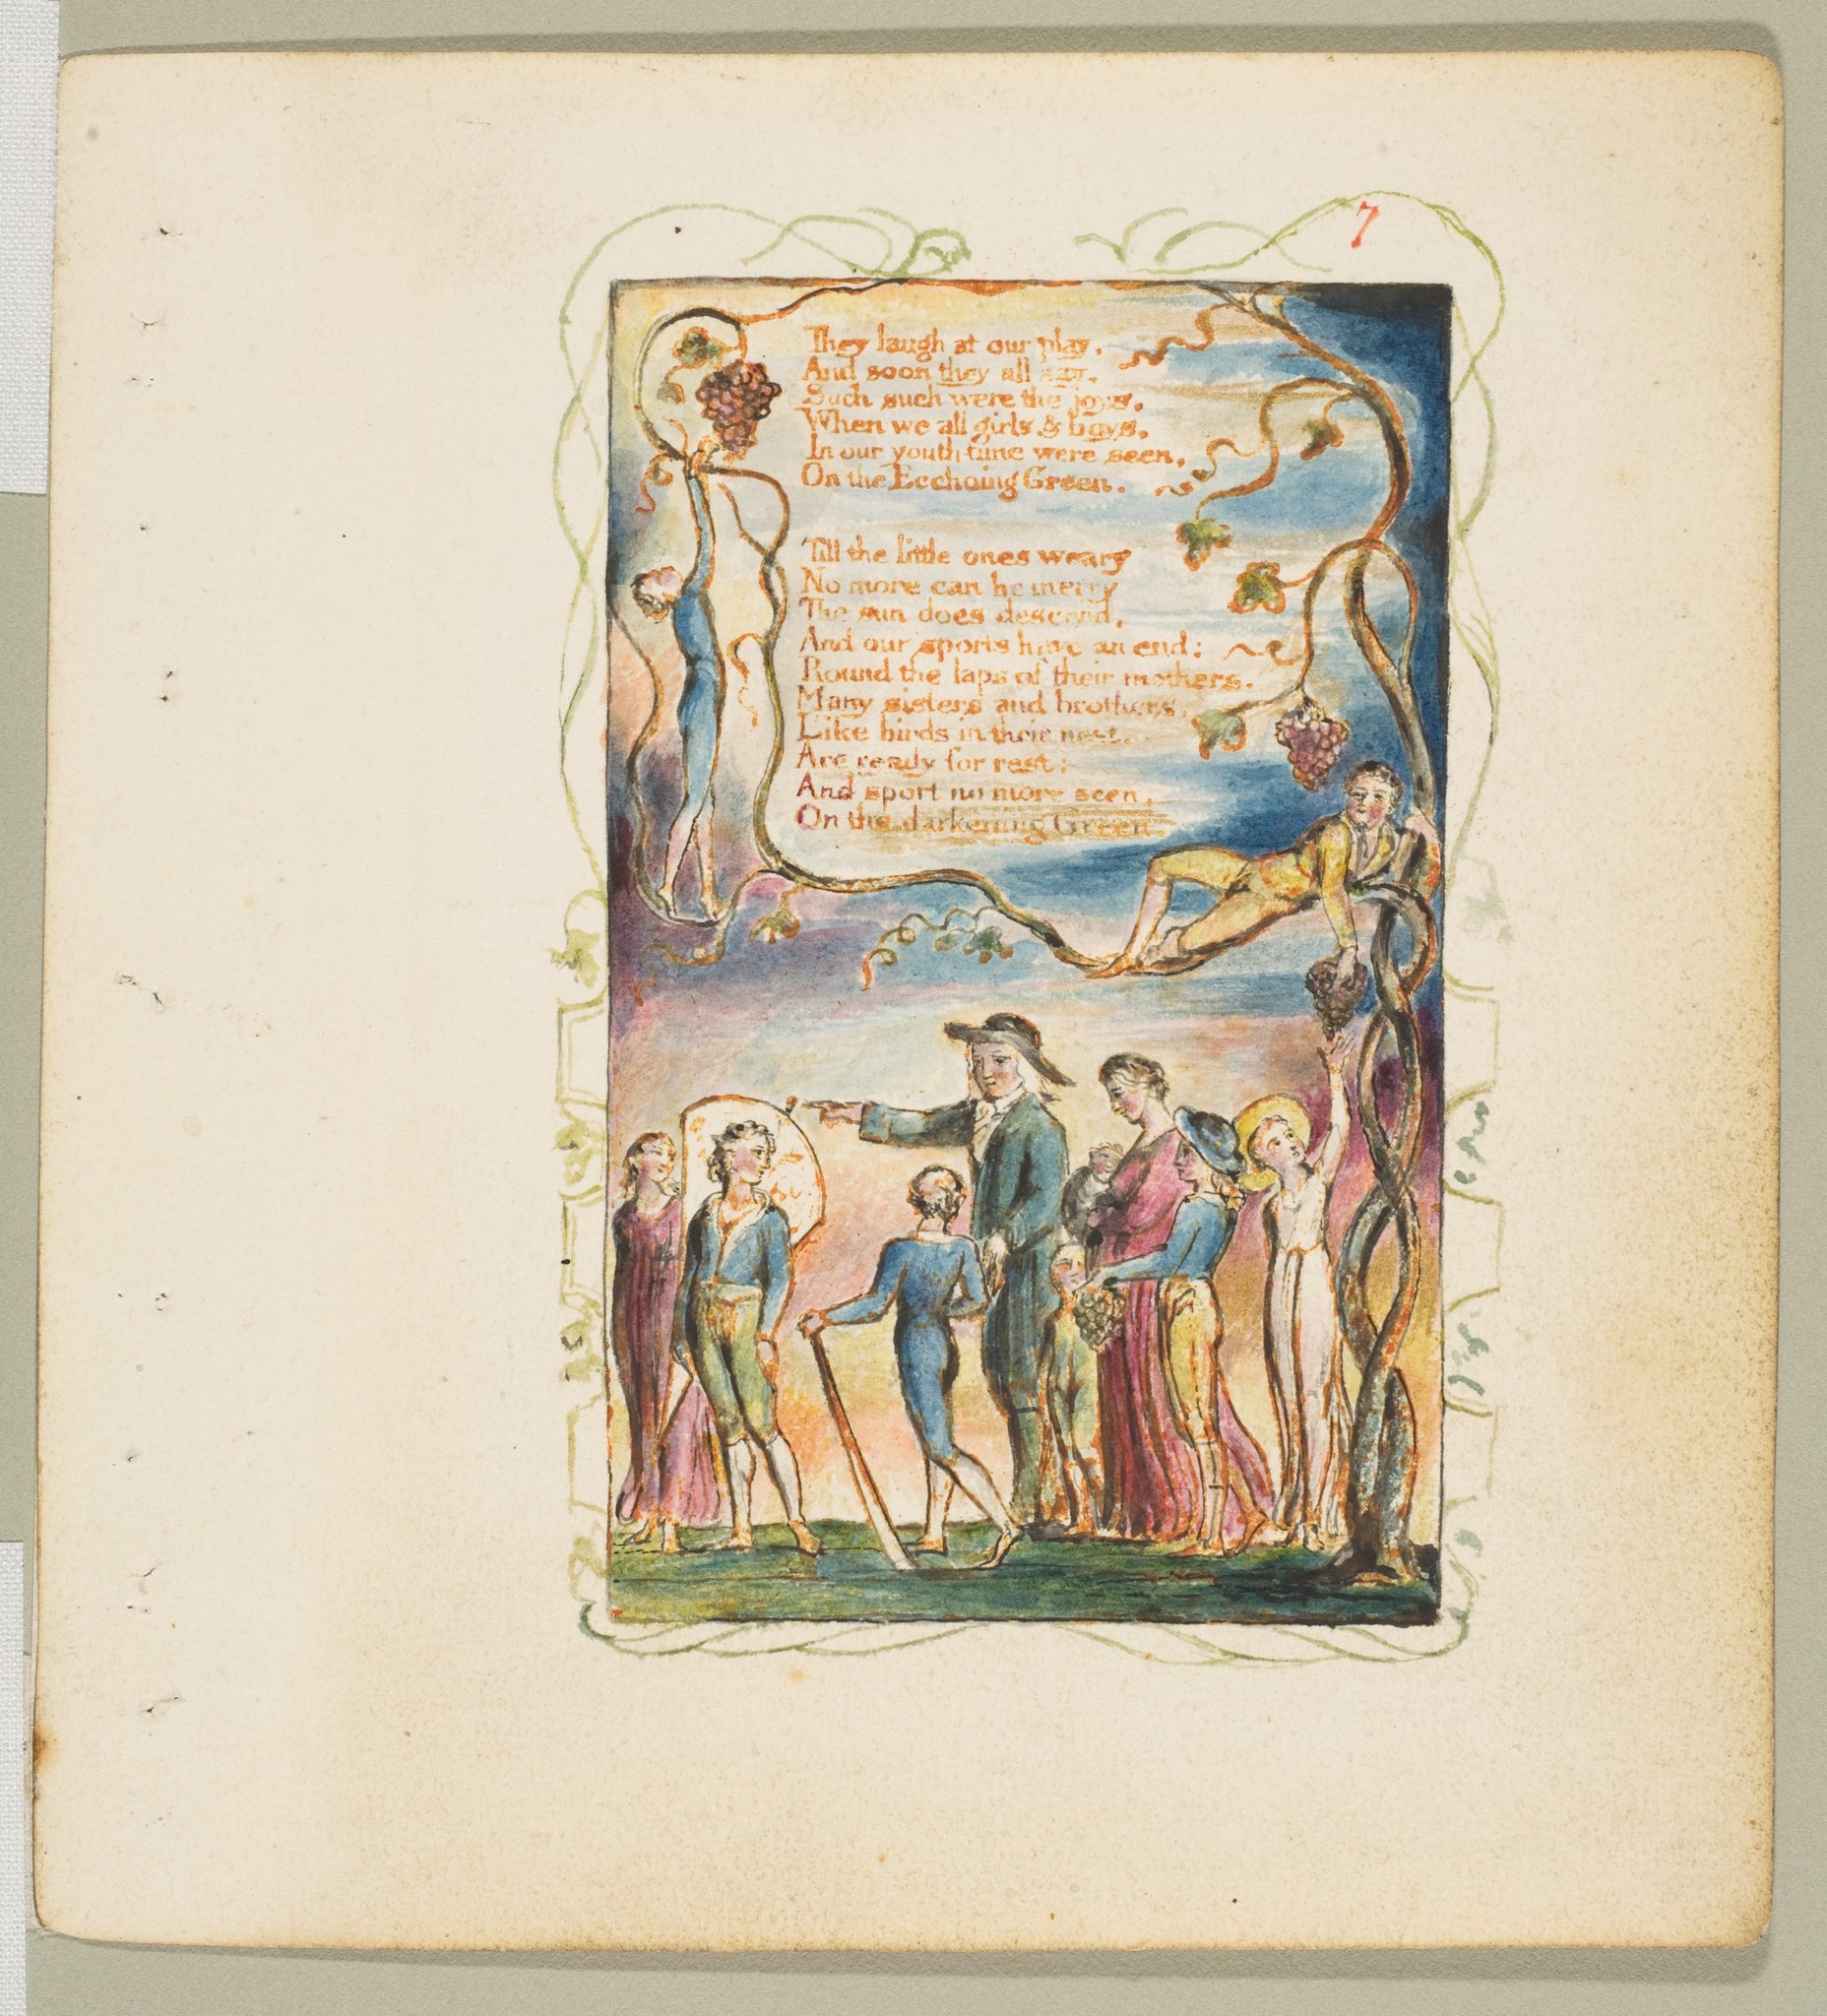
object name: print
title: Songs of Innocence: The Ecchoing Green (second plate)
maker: william blake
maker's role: artist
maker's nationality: british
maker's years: 1757-1827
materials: gold, ink, shell, watercolor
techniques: etching, hand coloring, printing, relief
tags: boys,girls,men,women